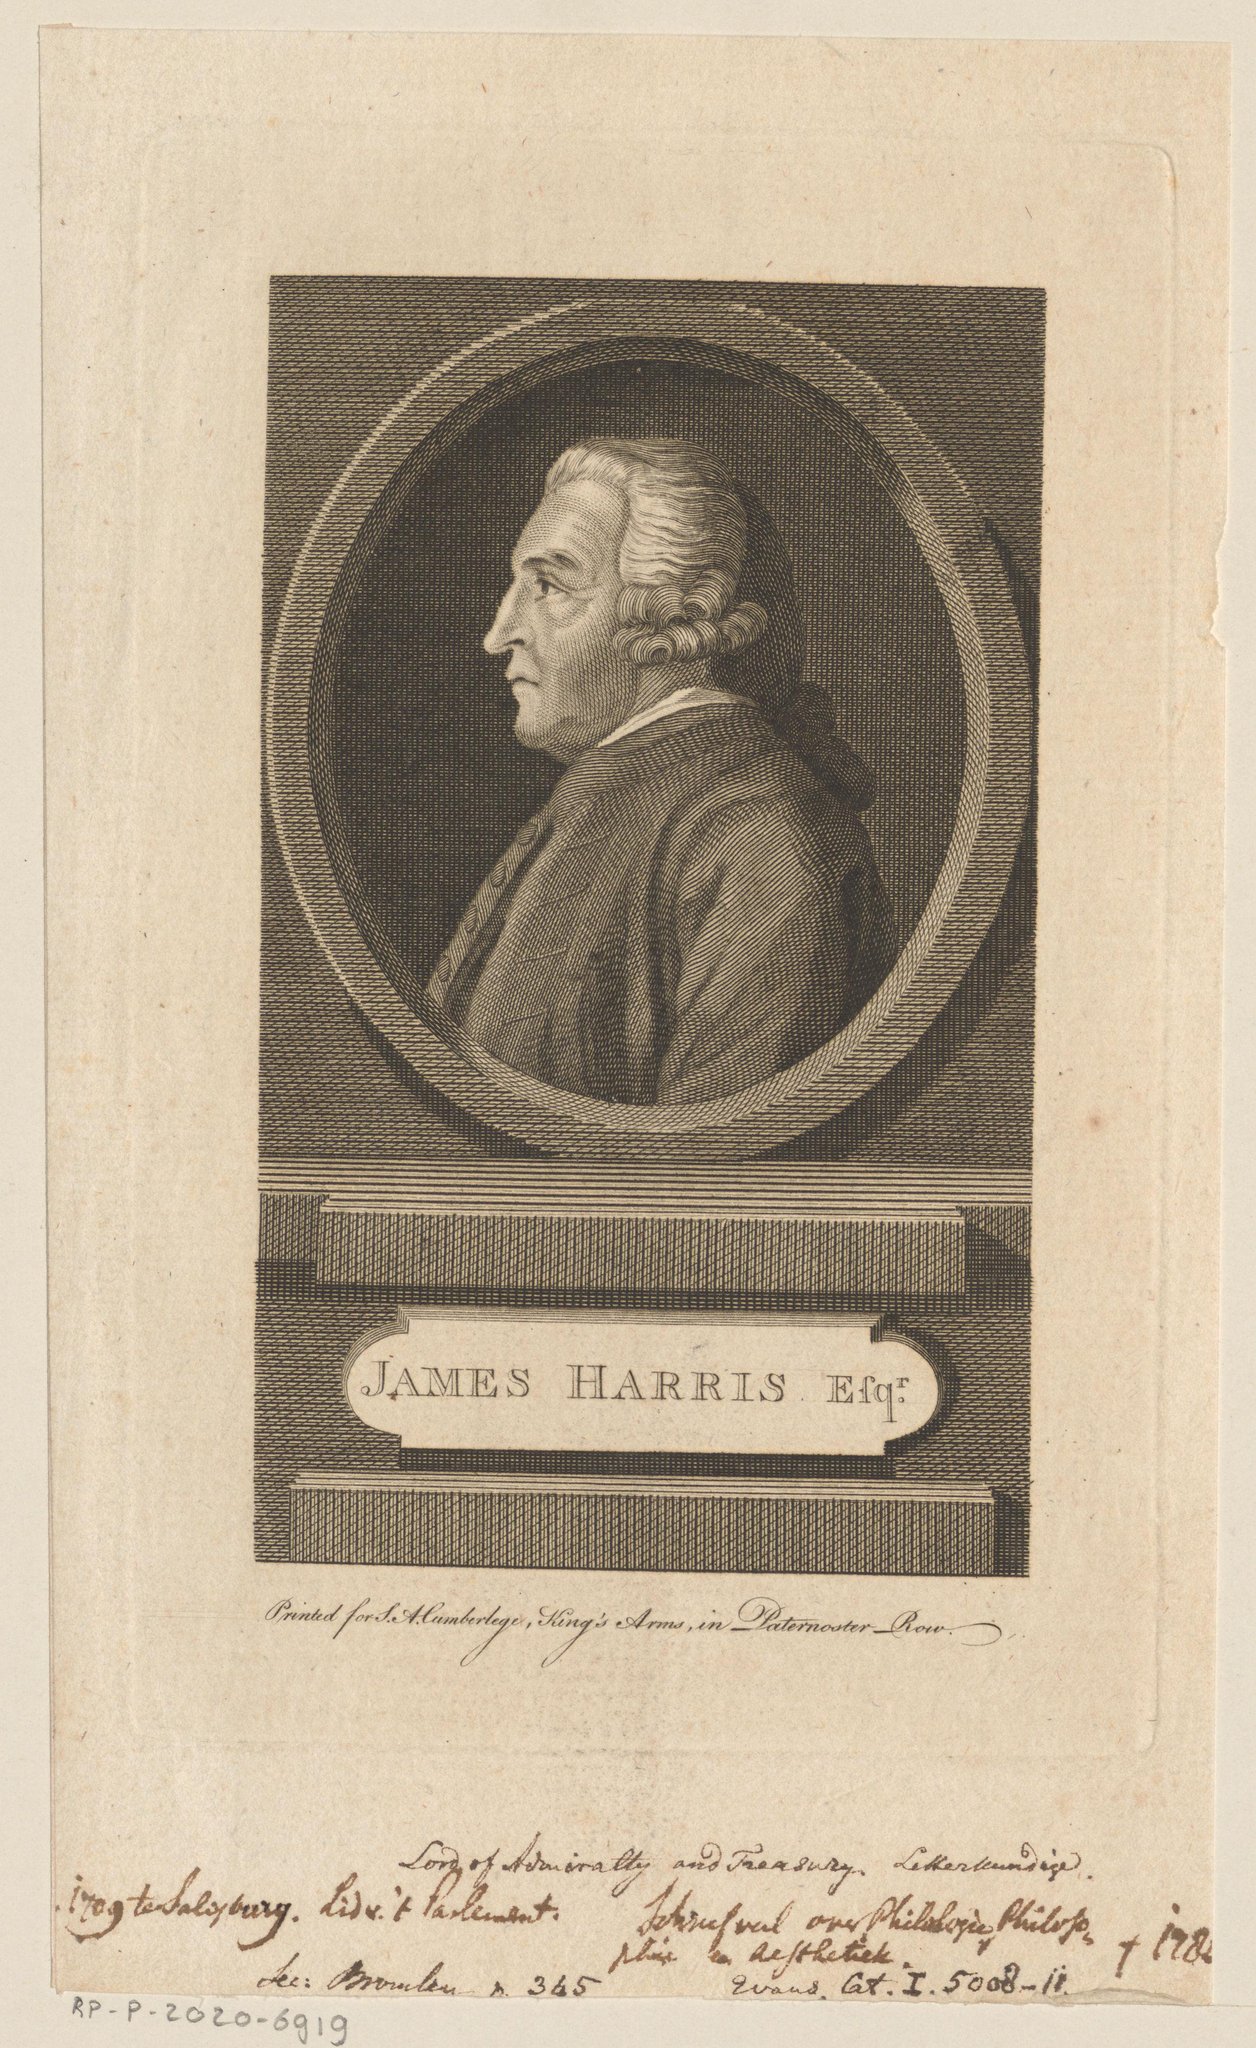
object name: print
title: Portret van James Harris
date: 1783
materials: paper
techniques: engraving, etching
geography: london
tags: politician, scholar, philosopher, historical persons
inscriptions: inscription: ‘Lord of Admiralty and Treasury, Letterkundige/ (...)’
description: Prent mogelijk uit: The Universal Magazine of Knowledge and Pleasure.